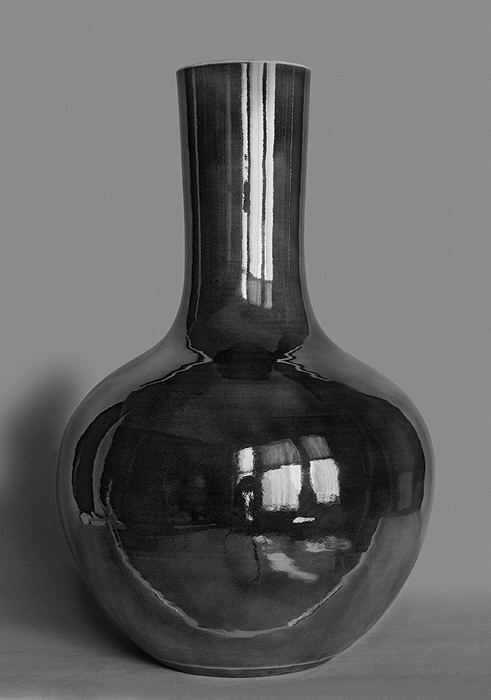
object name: vase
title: Gobular vase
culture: chinese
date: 1734-1766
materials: glaze, porcelain